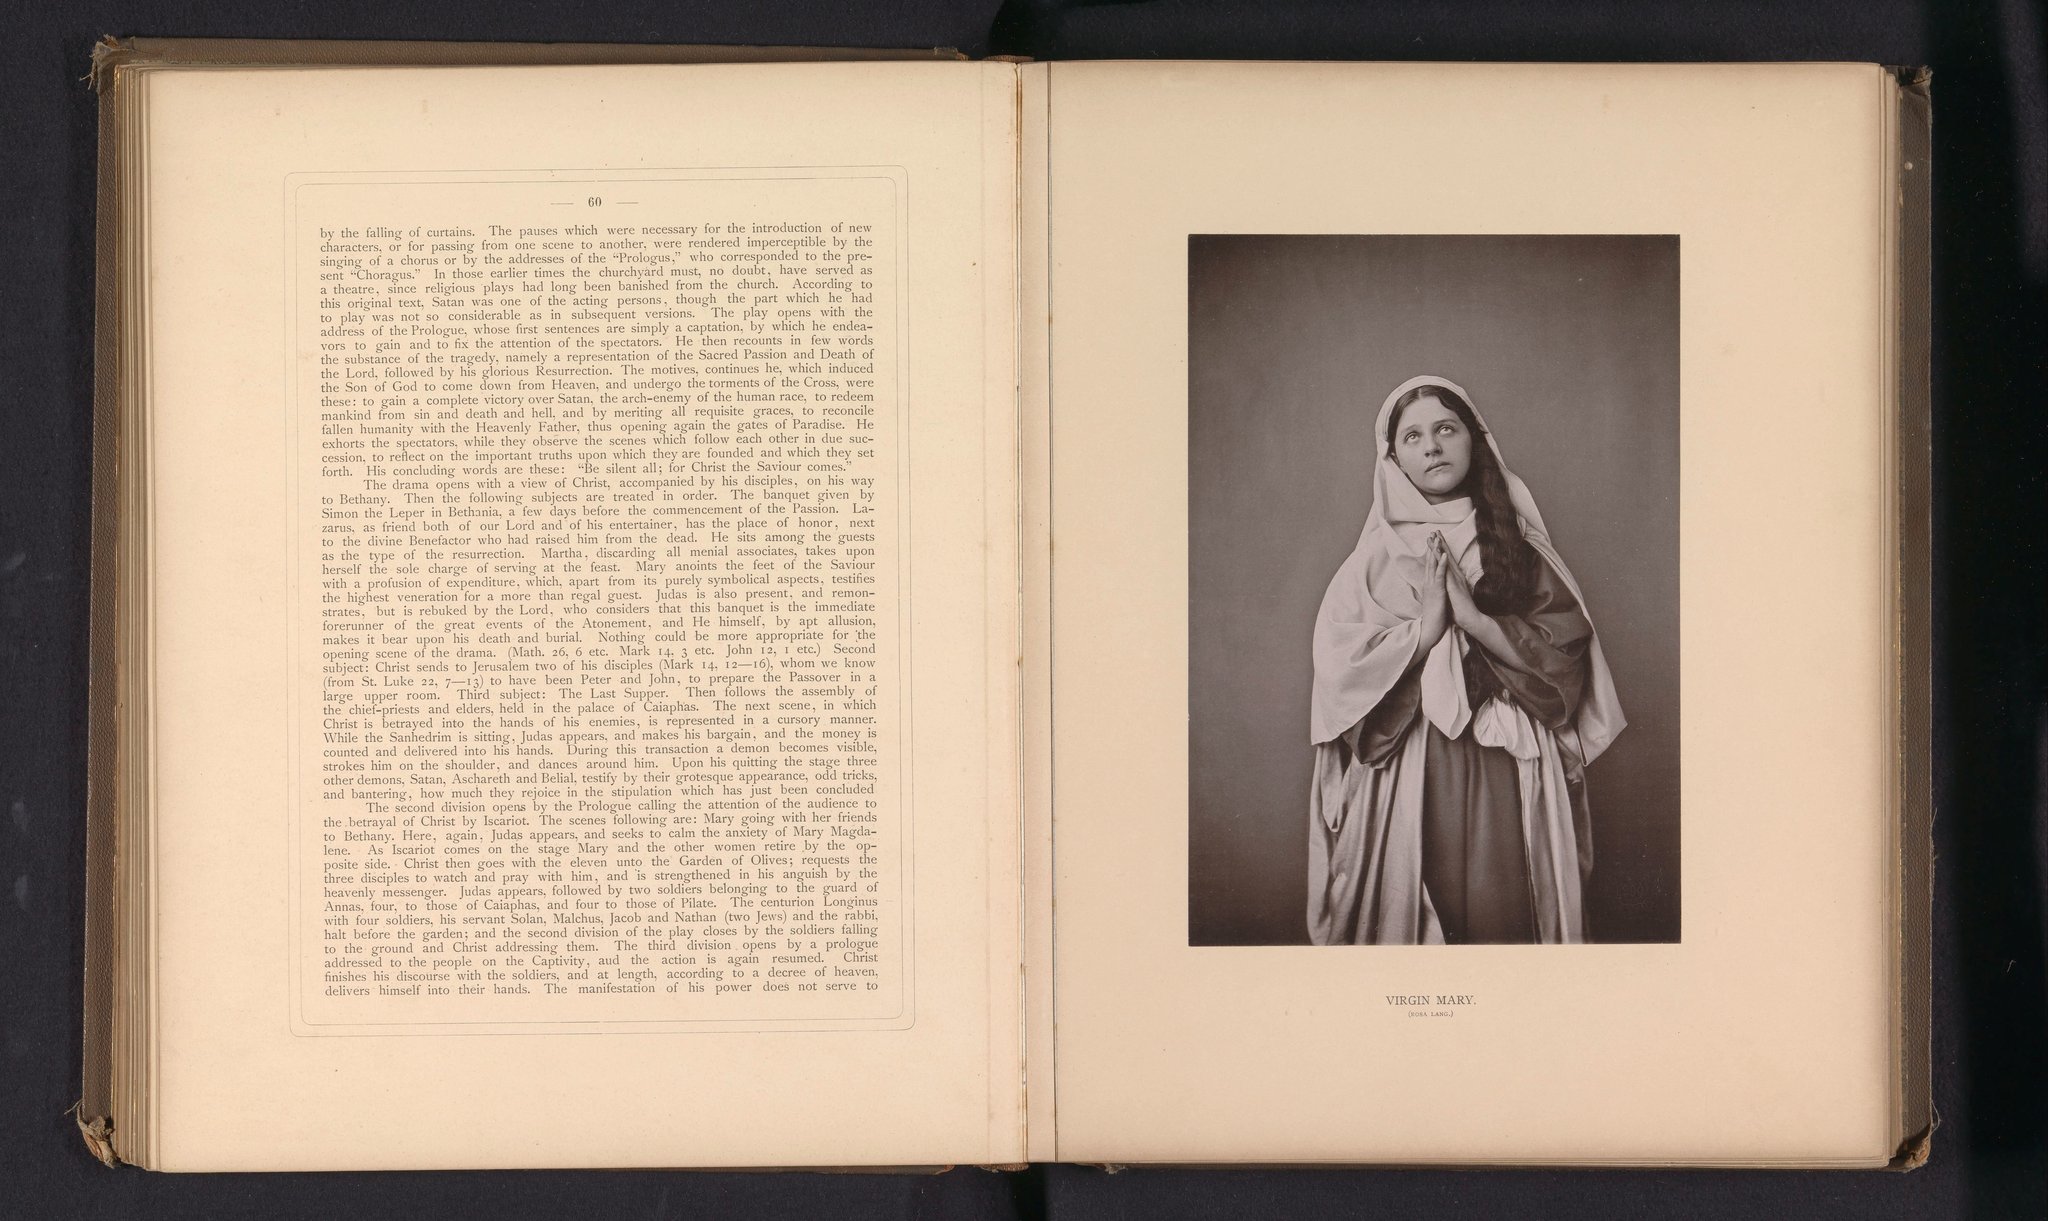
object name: photomechanical print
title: Virgin Mary (Rosa Lang)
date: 1885-1890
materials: paper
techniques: photograph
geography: oberammergau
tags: the virgin mary, portrait of actor, actress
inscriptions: inscription: ‘Gemeinde Oberammergau Passionsspiel 1890’